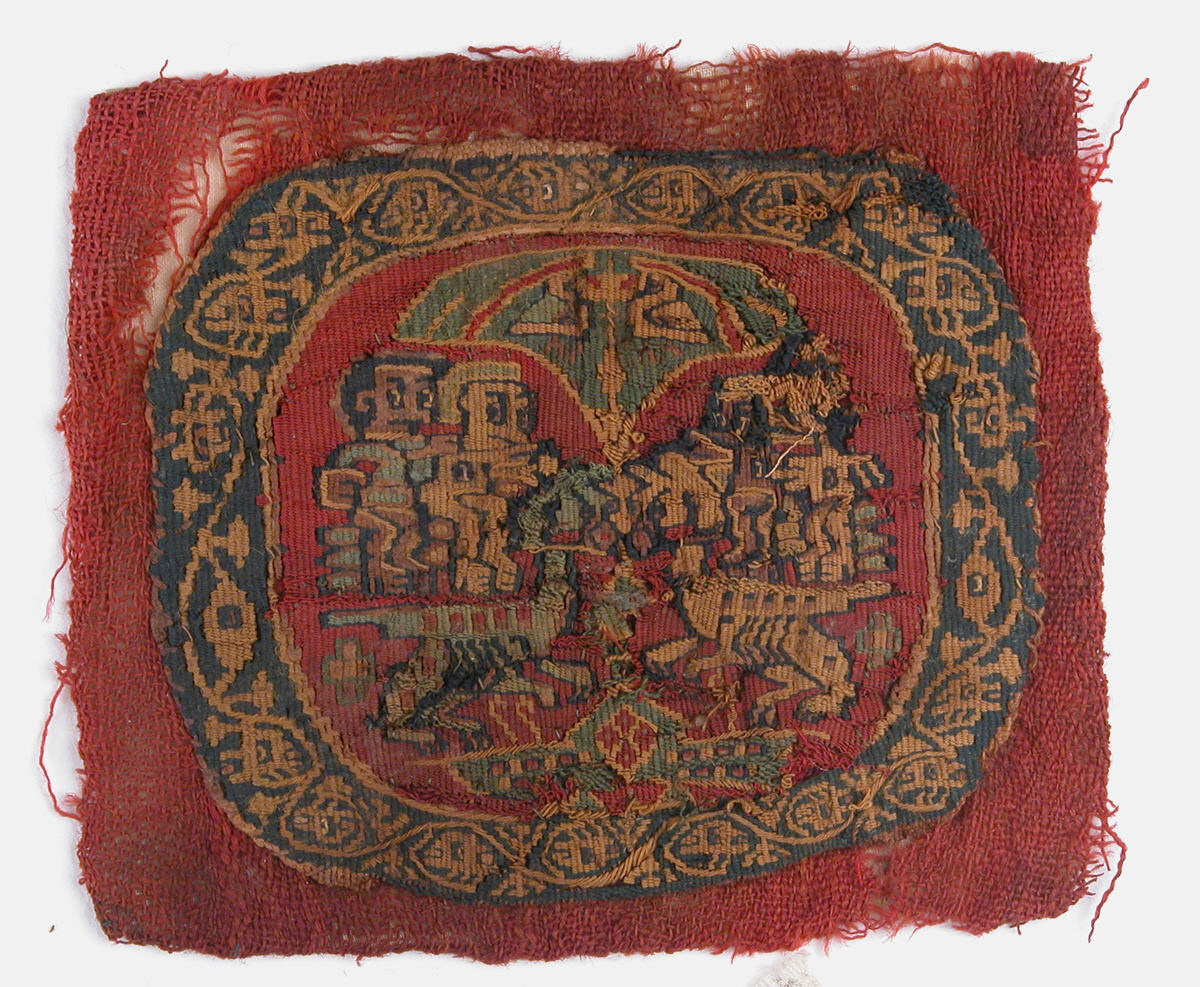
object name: roundel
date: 601-800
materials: linen, wool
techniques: weave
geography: egypt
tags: human figures